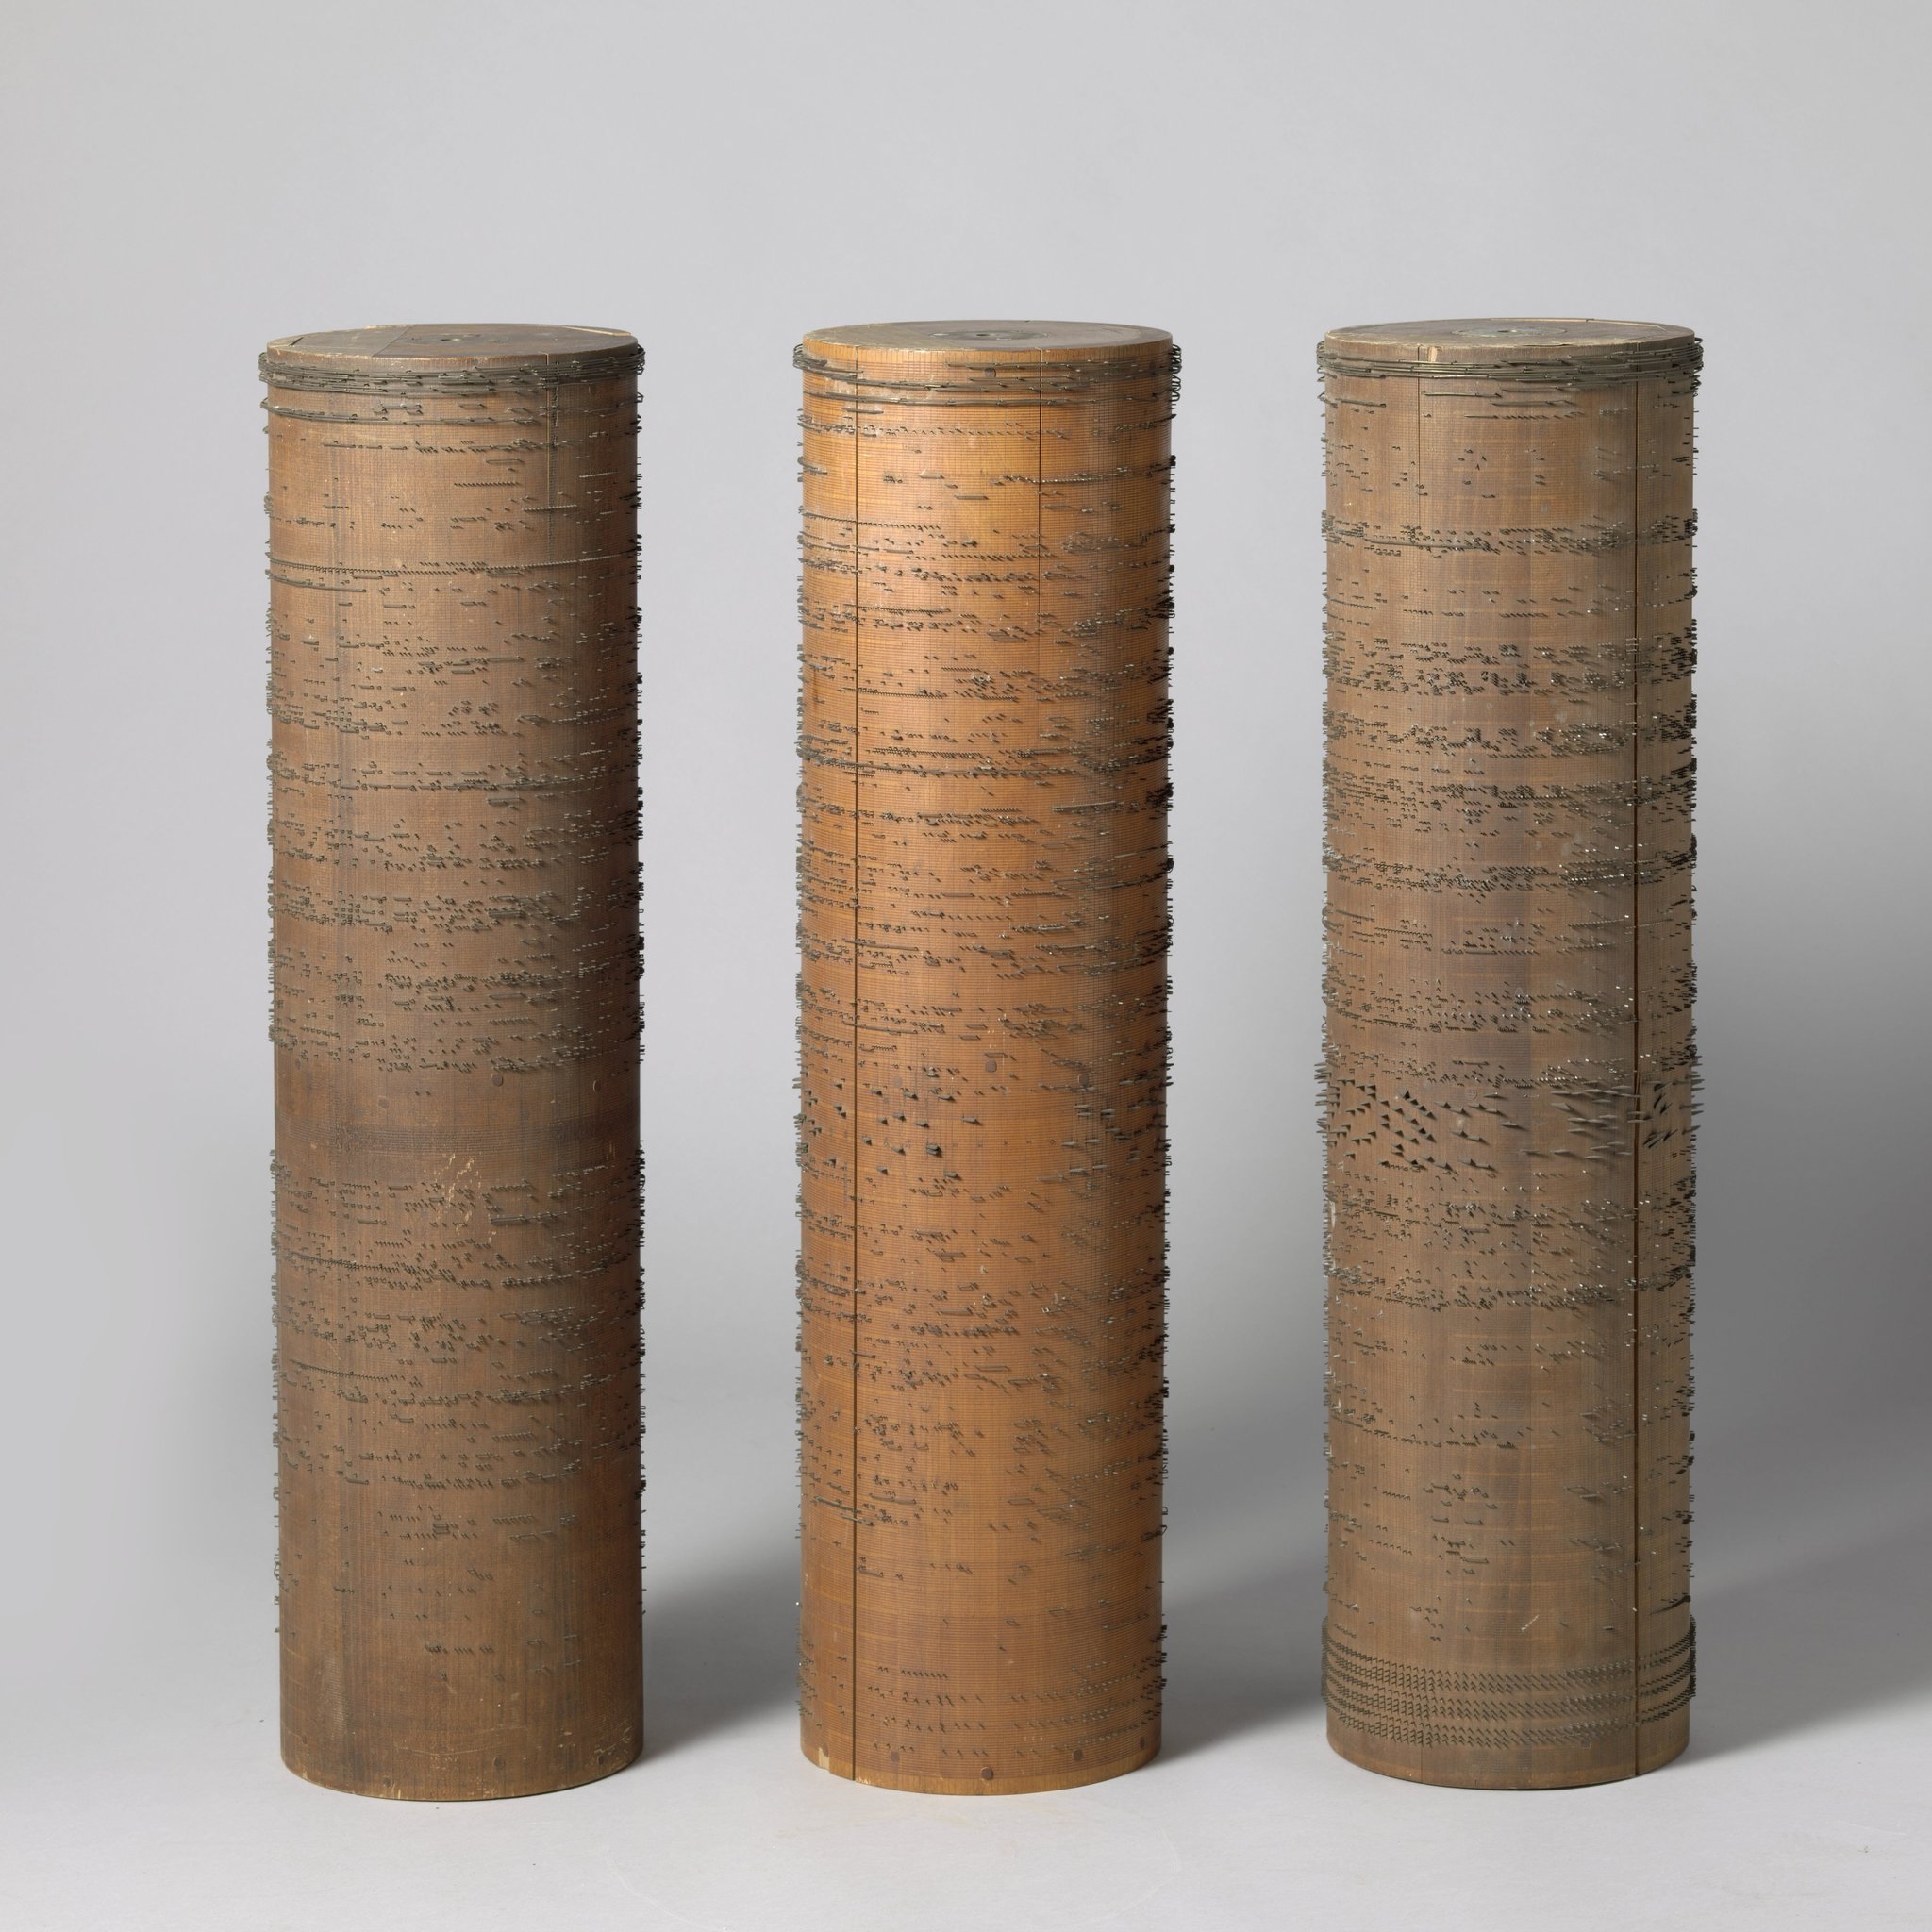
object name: barrel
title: Barrel for a mechanical organ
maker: harmanus dolman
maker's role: musical instrument maker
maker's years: 1787-1852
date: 1815-1825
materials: metal, wood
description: Cilinder voor een mechanisch orgel. 12 segmenten, 3 schroeven in messing plaat. Op de rol een etiket met handgeschreven tekst: Duo de Robert n. Bertram le Chevalier, Ballade de Raimbo, Duo de Raimbo, c'est aujourd'huit, Couplettes d'Alice, quant je quite, Sicilienne, l'or est une chimere, Grande Trio d'Alice, Lisant le testament.